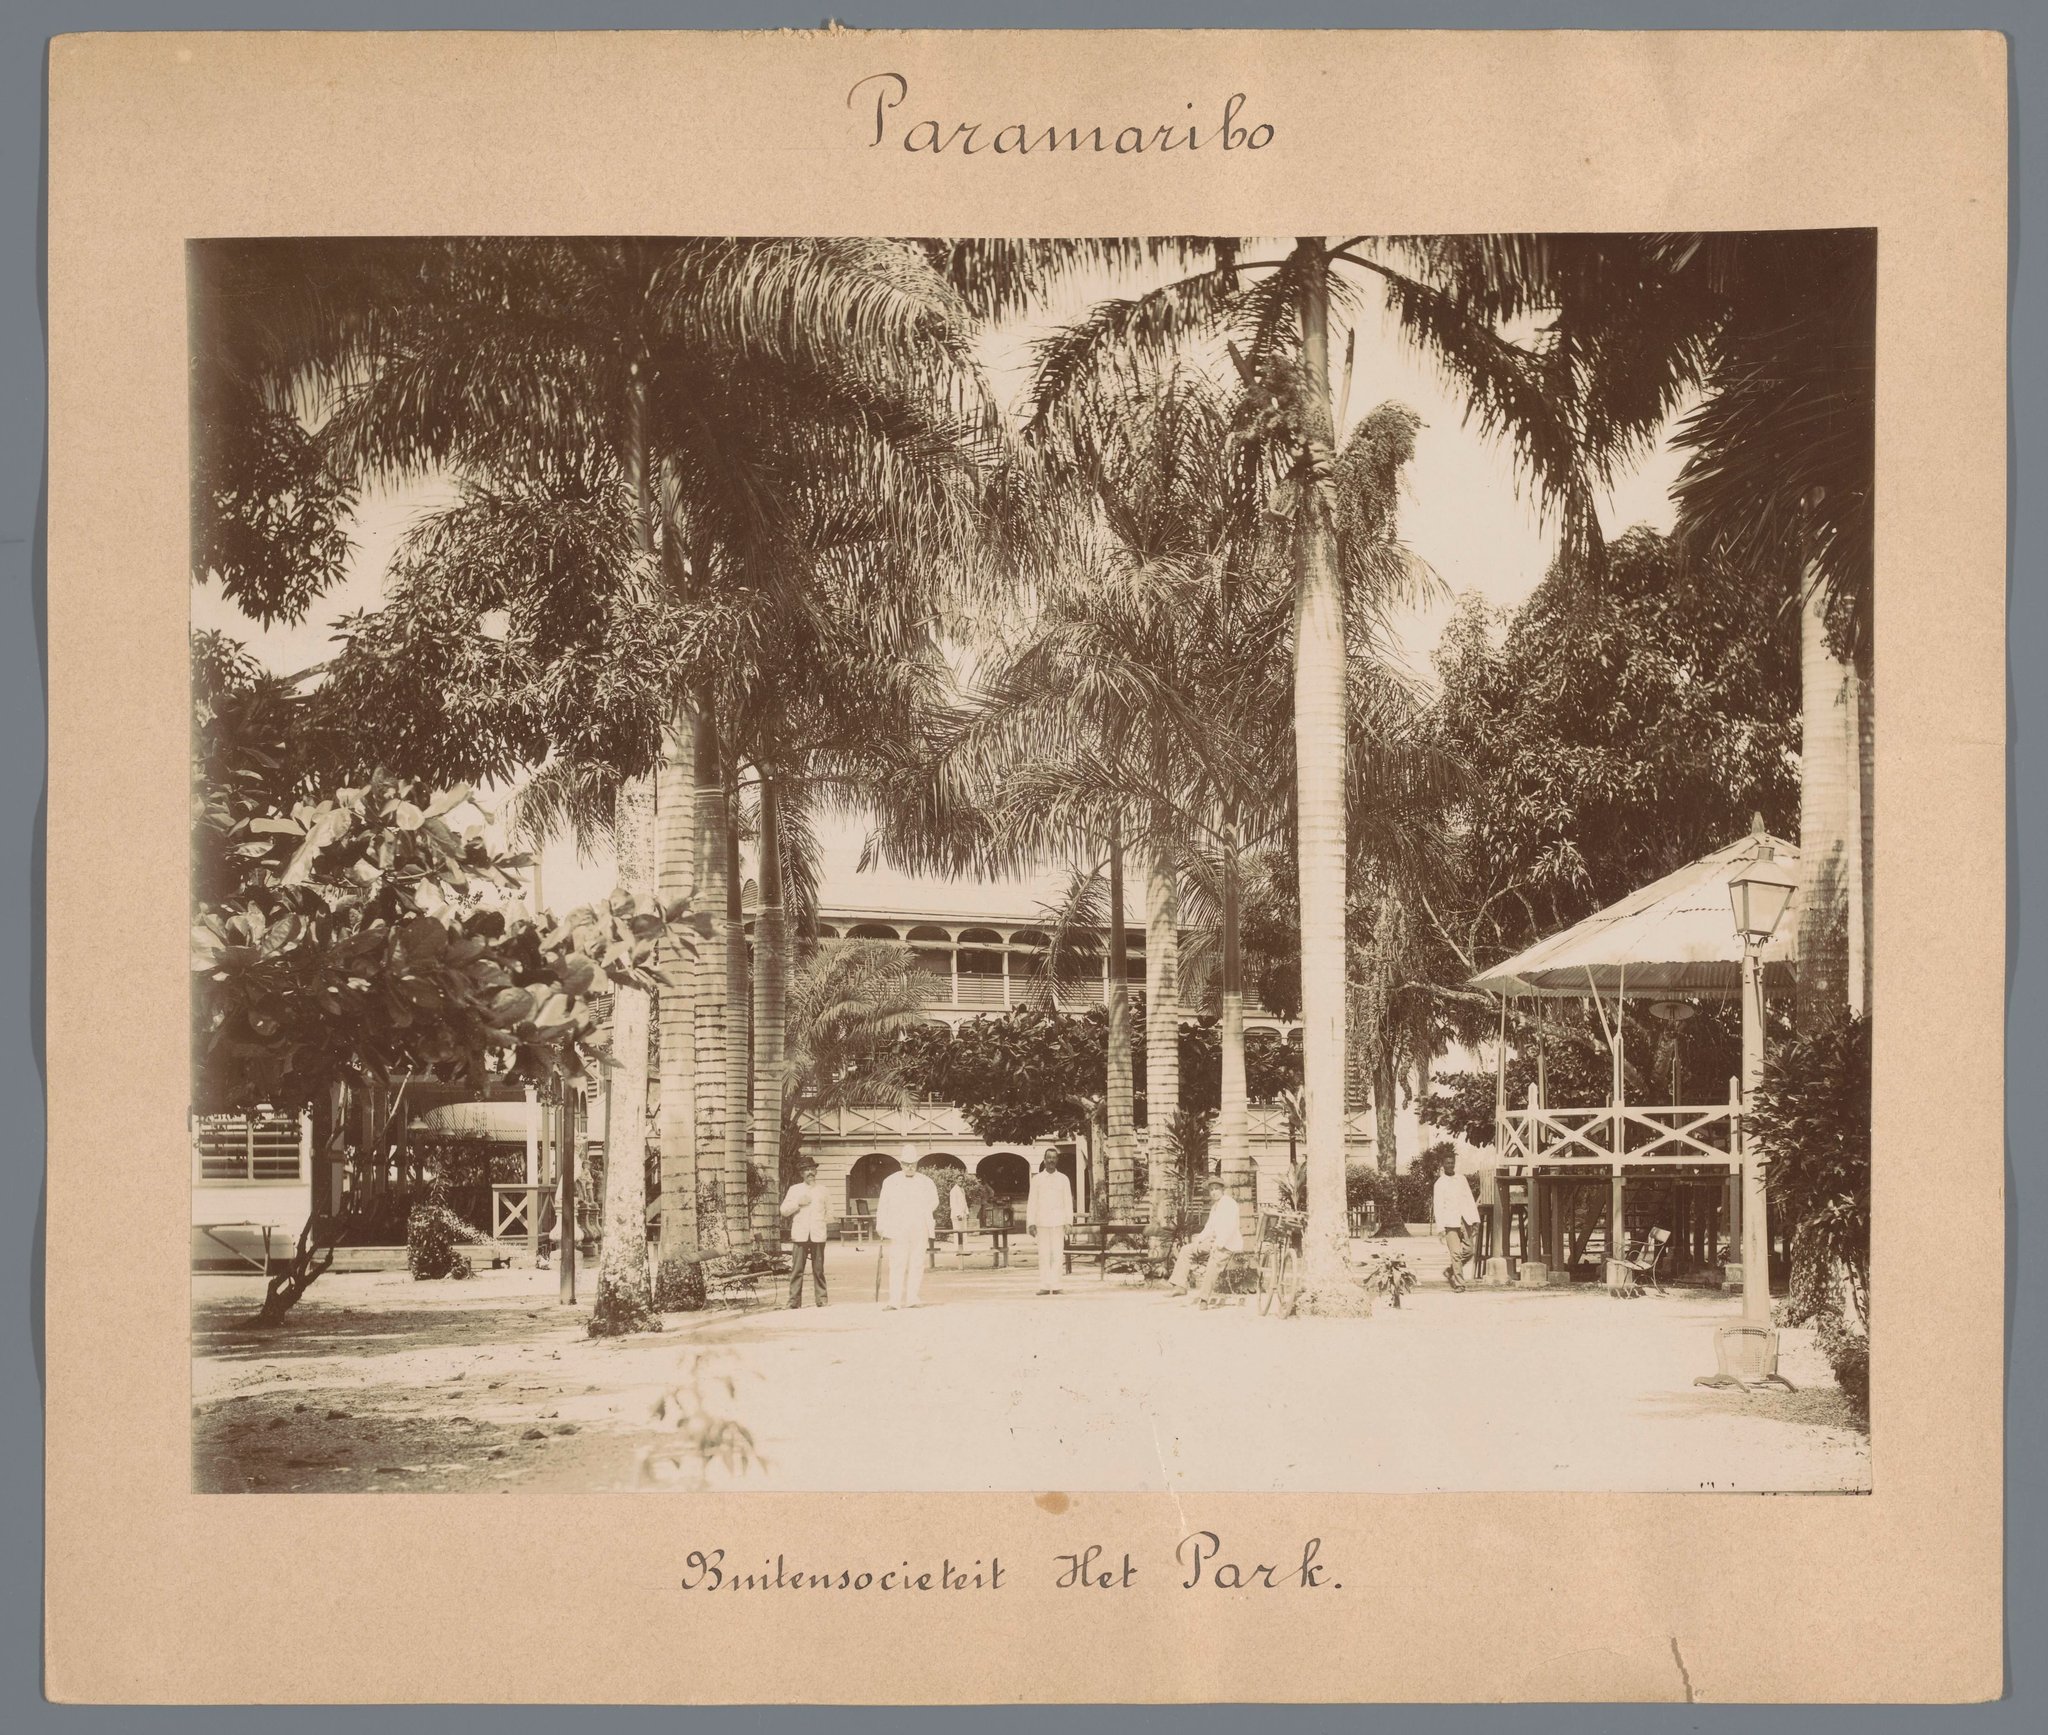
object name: photograph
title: Buitensocieteit Het Park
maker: eugen klein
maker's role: fotograaf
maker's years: 1869-1927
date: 1900-1905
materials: cardboard, photographic support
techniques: gelatin silver print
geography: paramaribo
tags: het park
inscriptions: inscription: ‘Paramaribo / Buitensocieteit Het Park’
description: Gezicht op gebouwen en terras van de sociëteit Het Park te Paramaribo. Onderdeel van een groep van 44 foto's van Paramaribo, Suriname en Curaçao, ca. 1900-1905, opgeplakt op kartons en voorzien van opschriften.